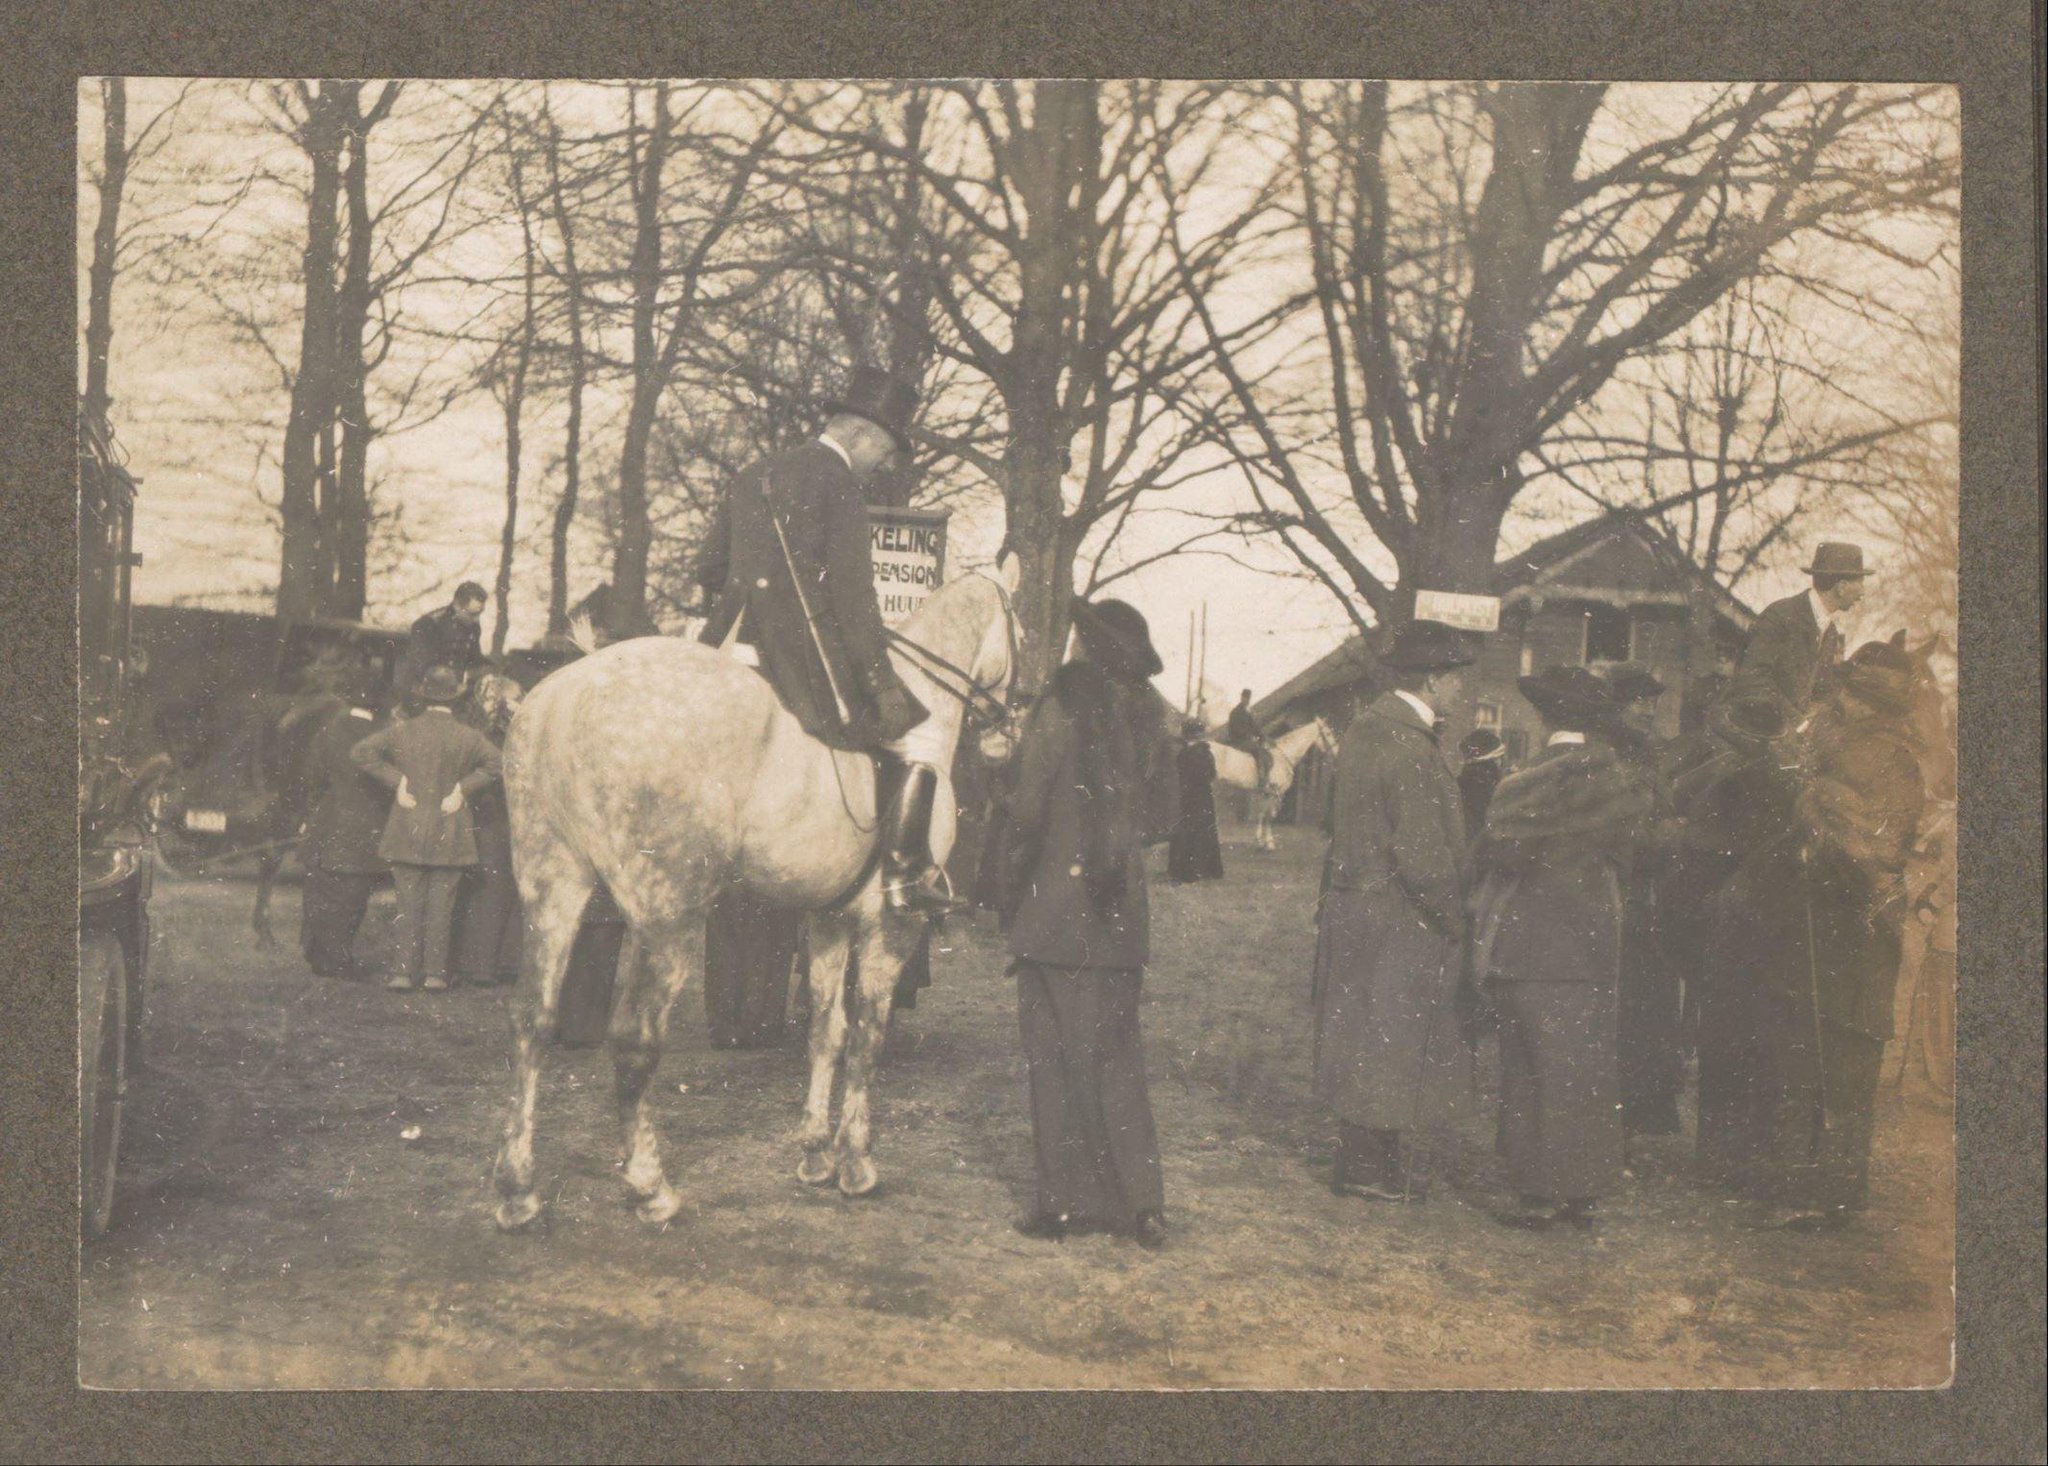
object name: photograph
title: Ruitertafereel op Koninklijke Houtvesterij Het Loo: gezelschap en ruiters bij café de Krakeling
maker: Anonymous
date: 1900-1925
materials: photographic support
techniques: gelatin silver print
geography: het loo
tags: riding a horse, ass, or mule; rider, horseman, advertising, hunting, chase, hunting-ground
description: Onderdeel van Fotoalbum van de heer Brams, opperhoutvester van koningin Wilhelmina op Koninklijke Houtvesterij Het Loo.